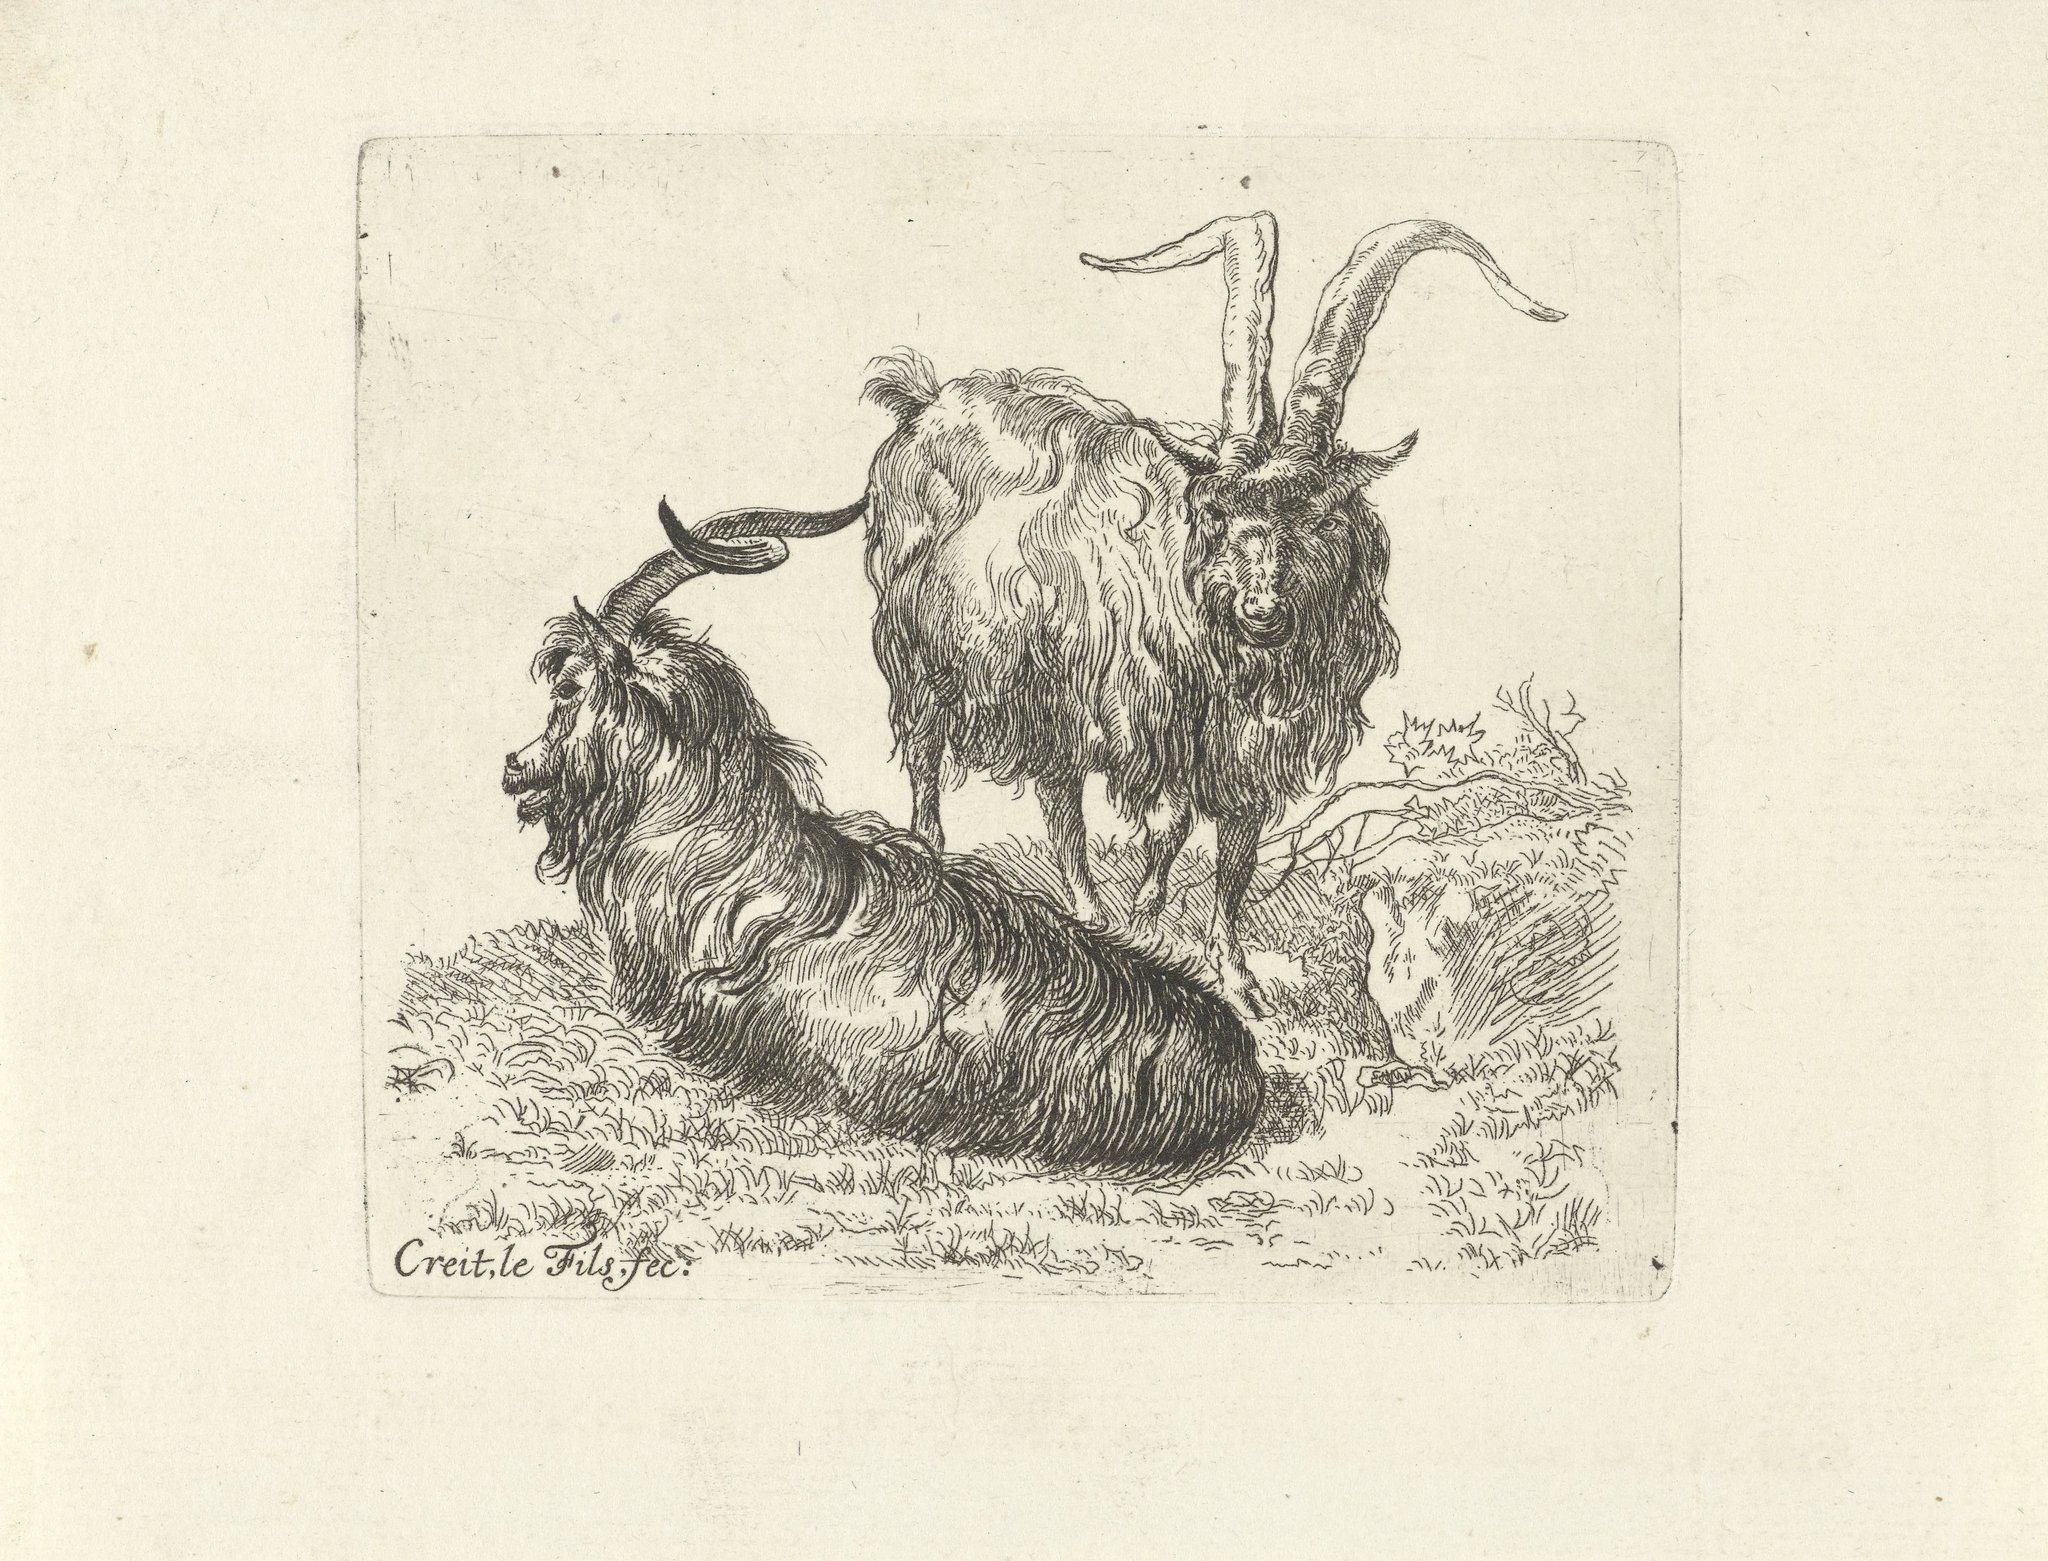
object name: print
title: Twee rammen in een weide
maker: ernst ludwig creite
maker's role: print maker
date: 1728-1756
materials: paper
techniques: etching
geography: the hague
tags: ram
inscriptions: collector's mark: Lugt 240